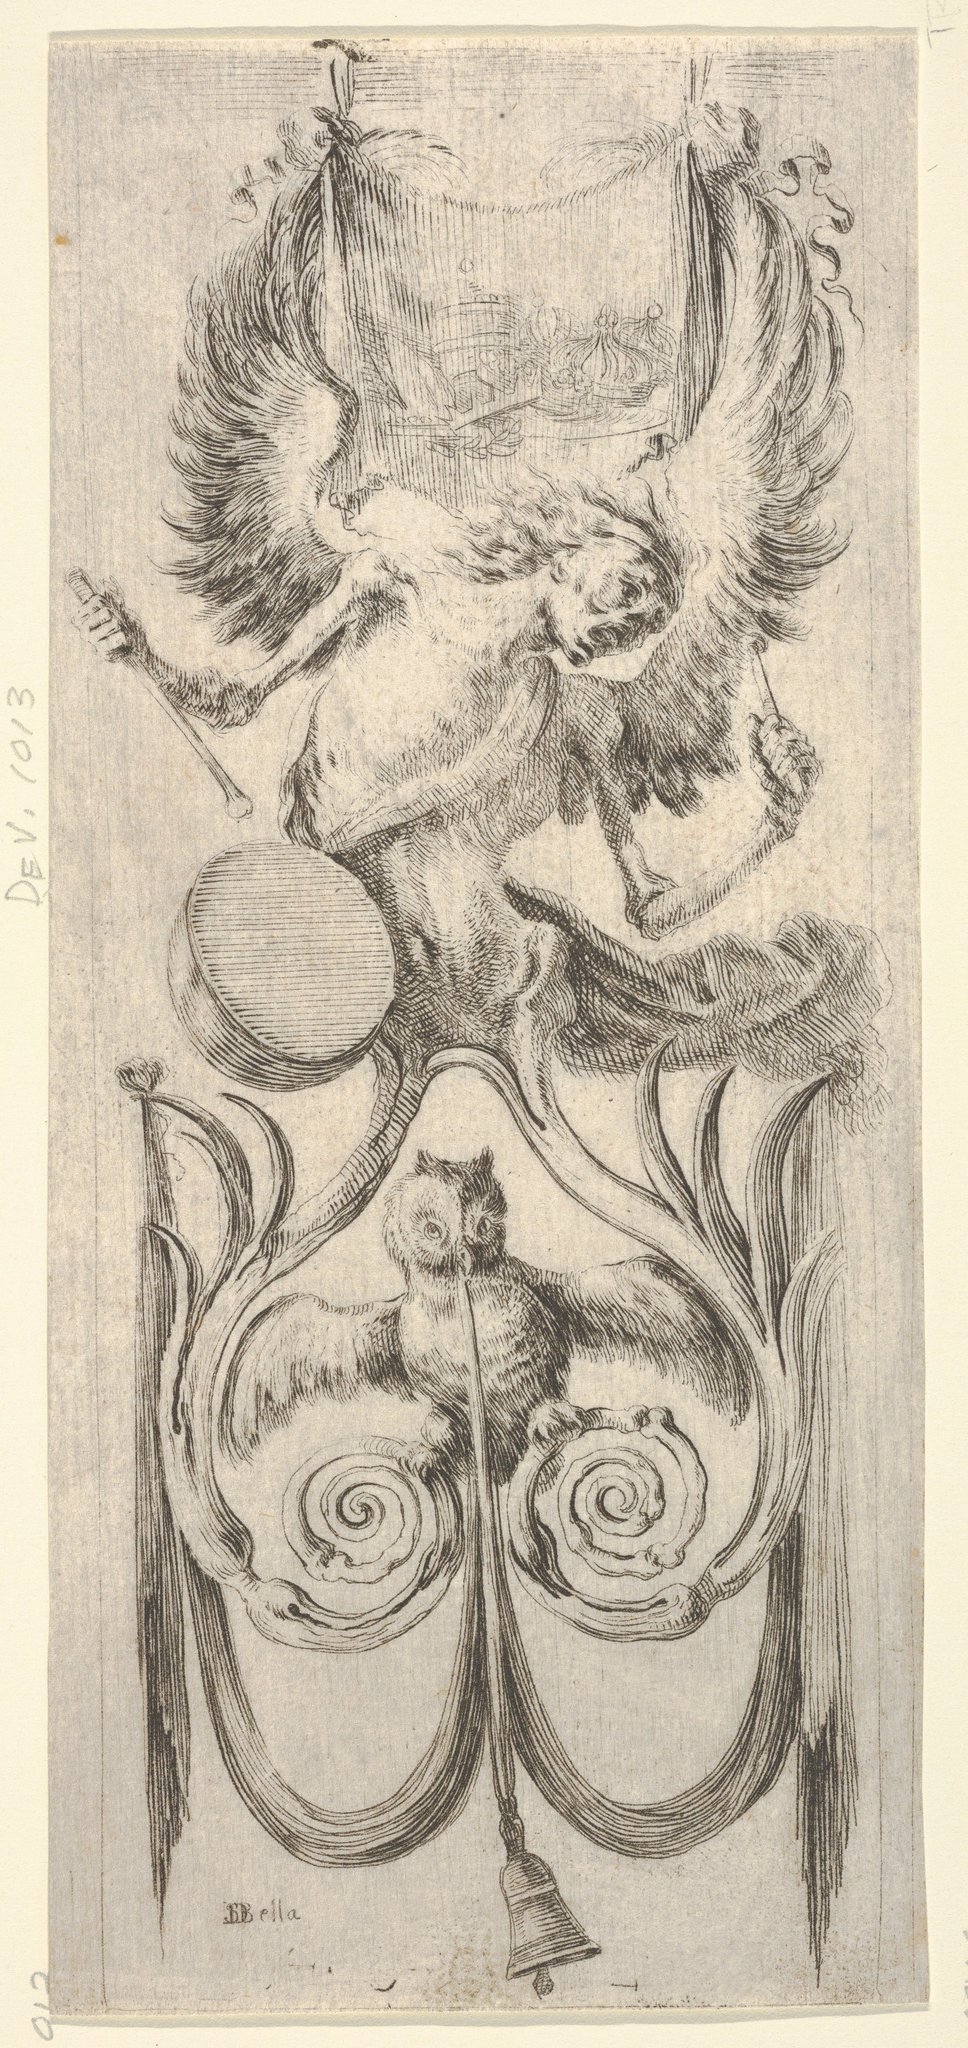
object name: print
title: Death beating a drum above, an owl and a bell attached to a ribbon below, from "Ornaments or Grotesques" (Ornamenti o Grottesche)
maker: stefano della bella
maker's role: artist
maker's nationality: italian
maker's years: 1610-1664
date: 1650-1656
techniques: etching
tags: drums,owls